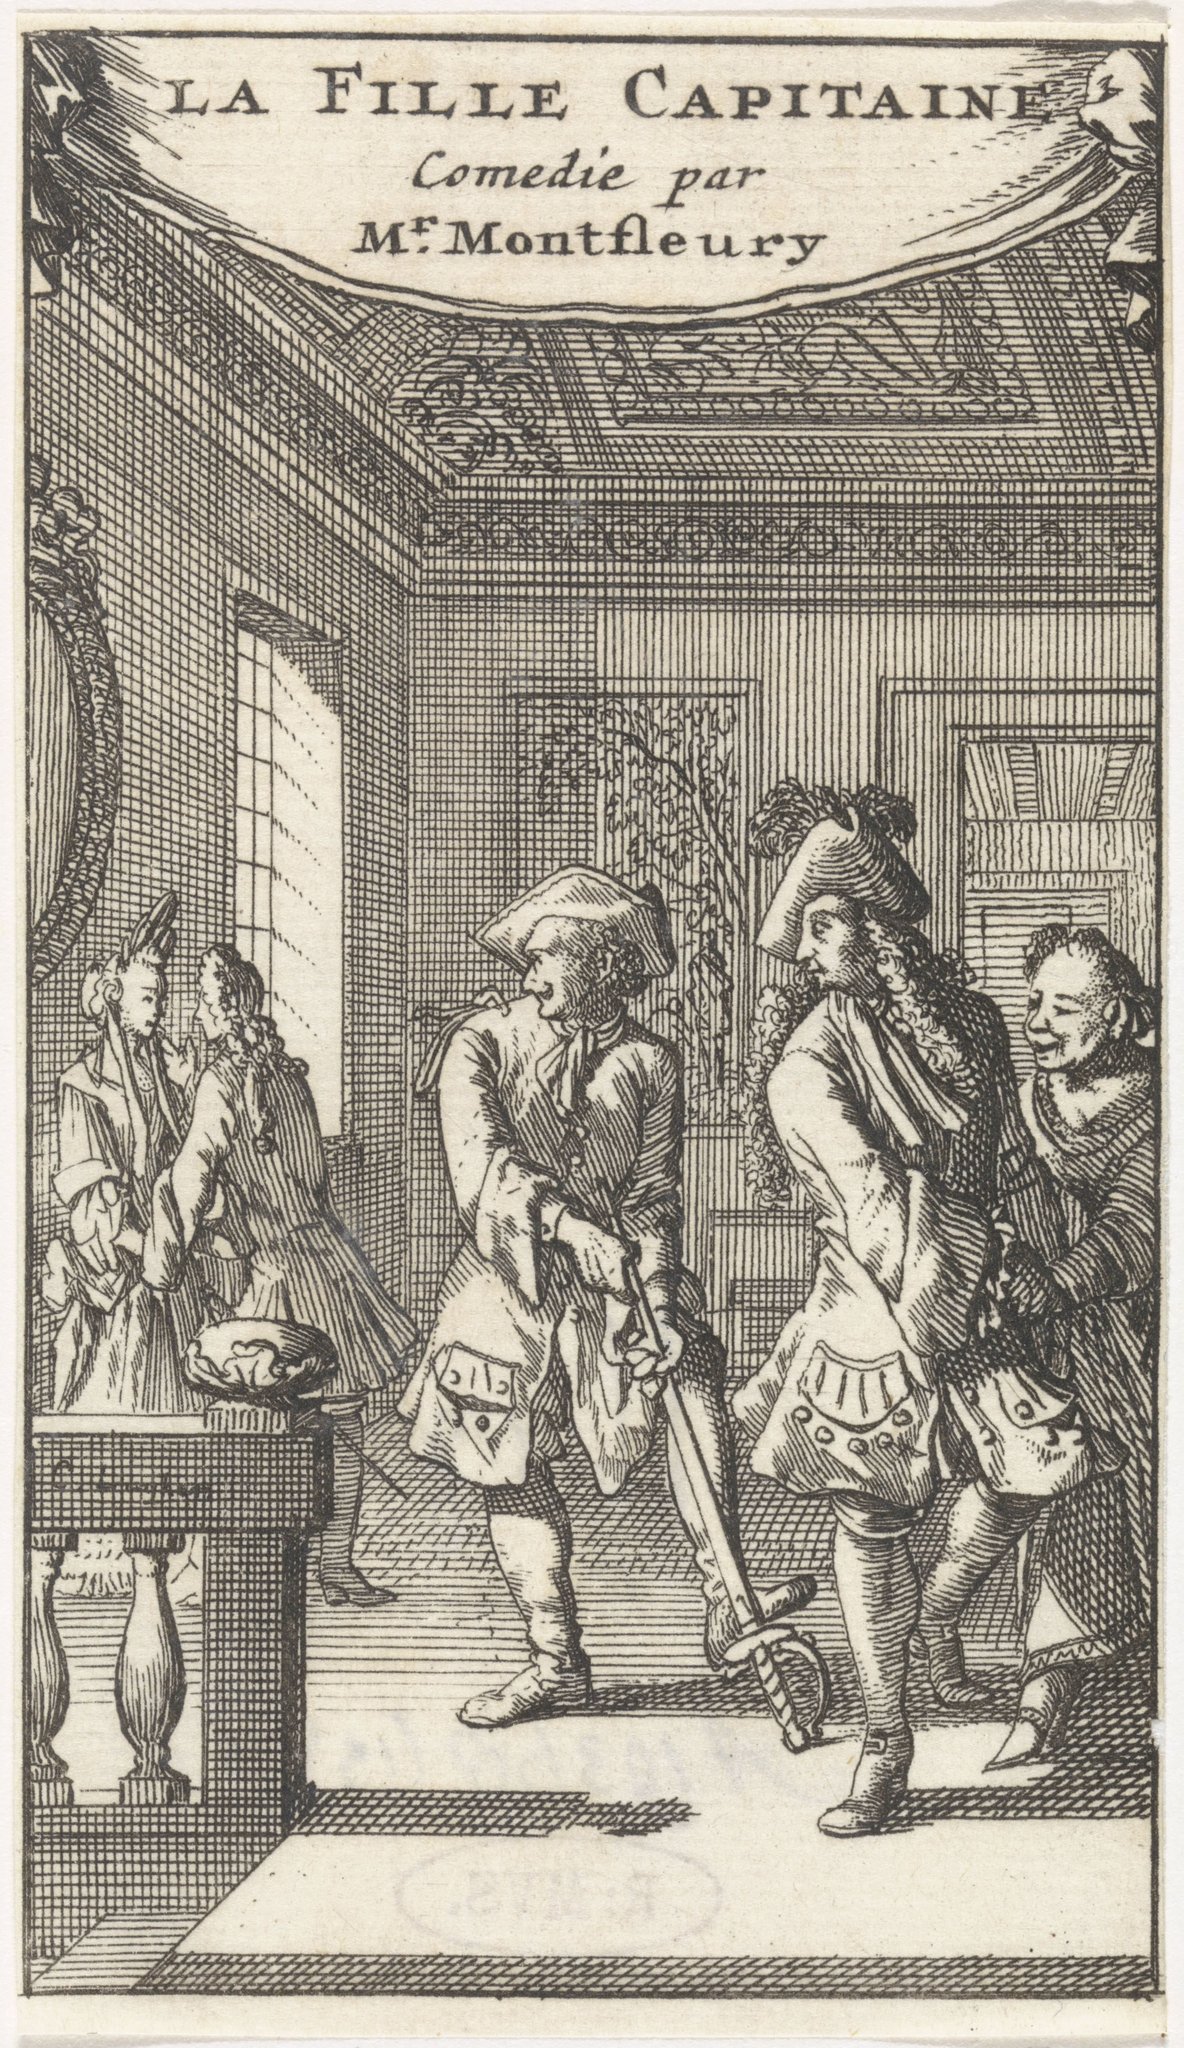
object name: print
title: Titelpagina voor het toneelstuk 'La Fille Capitaine' van A.J. Montfleury, 1698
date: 1698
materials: paper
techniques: etching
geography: amsterdam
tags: lovers; courting, flirting, hacking and thrusting weapons: rapier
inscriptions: collector's mark: Lugt 2228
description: Titelpagina voor het toneelstuk 'La Fille Capitaine' in: Montfleury, Antoine Jacob. Les oeuvres, 2 delen. Amsterdam: Adriaan Braakman, 1698, dl. I.